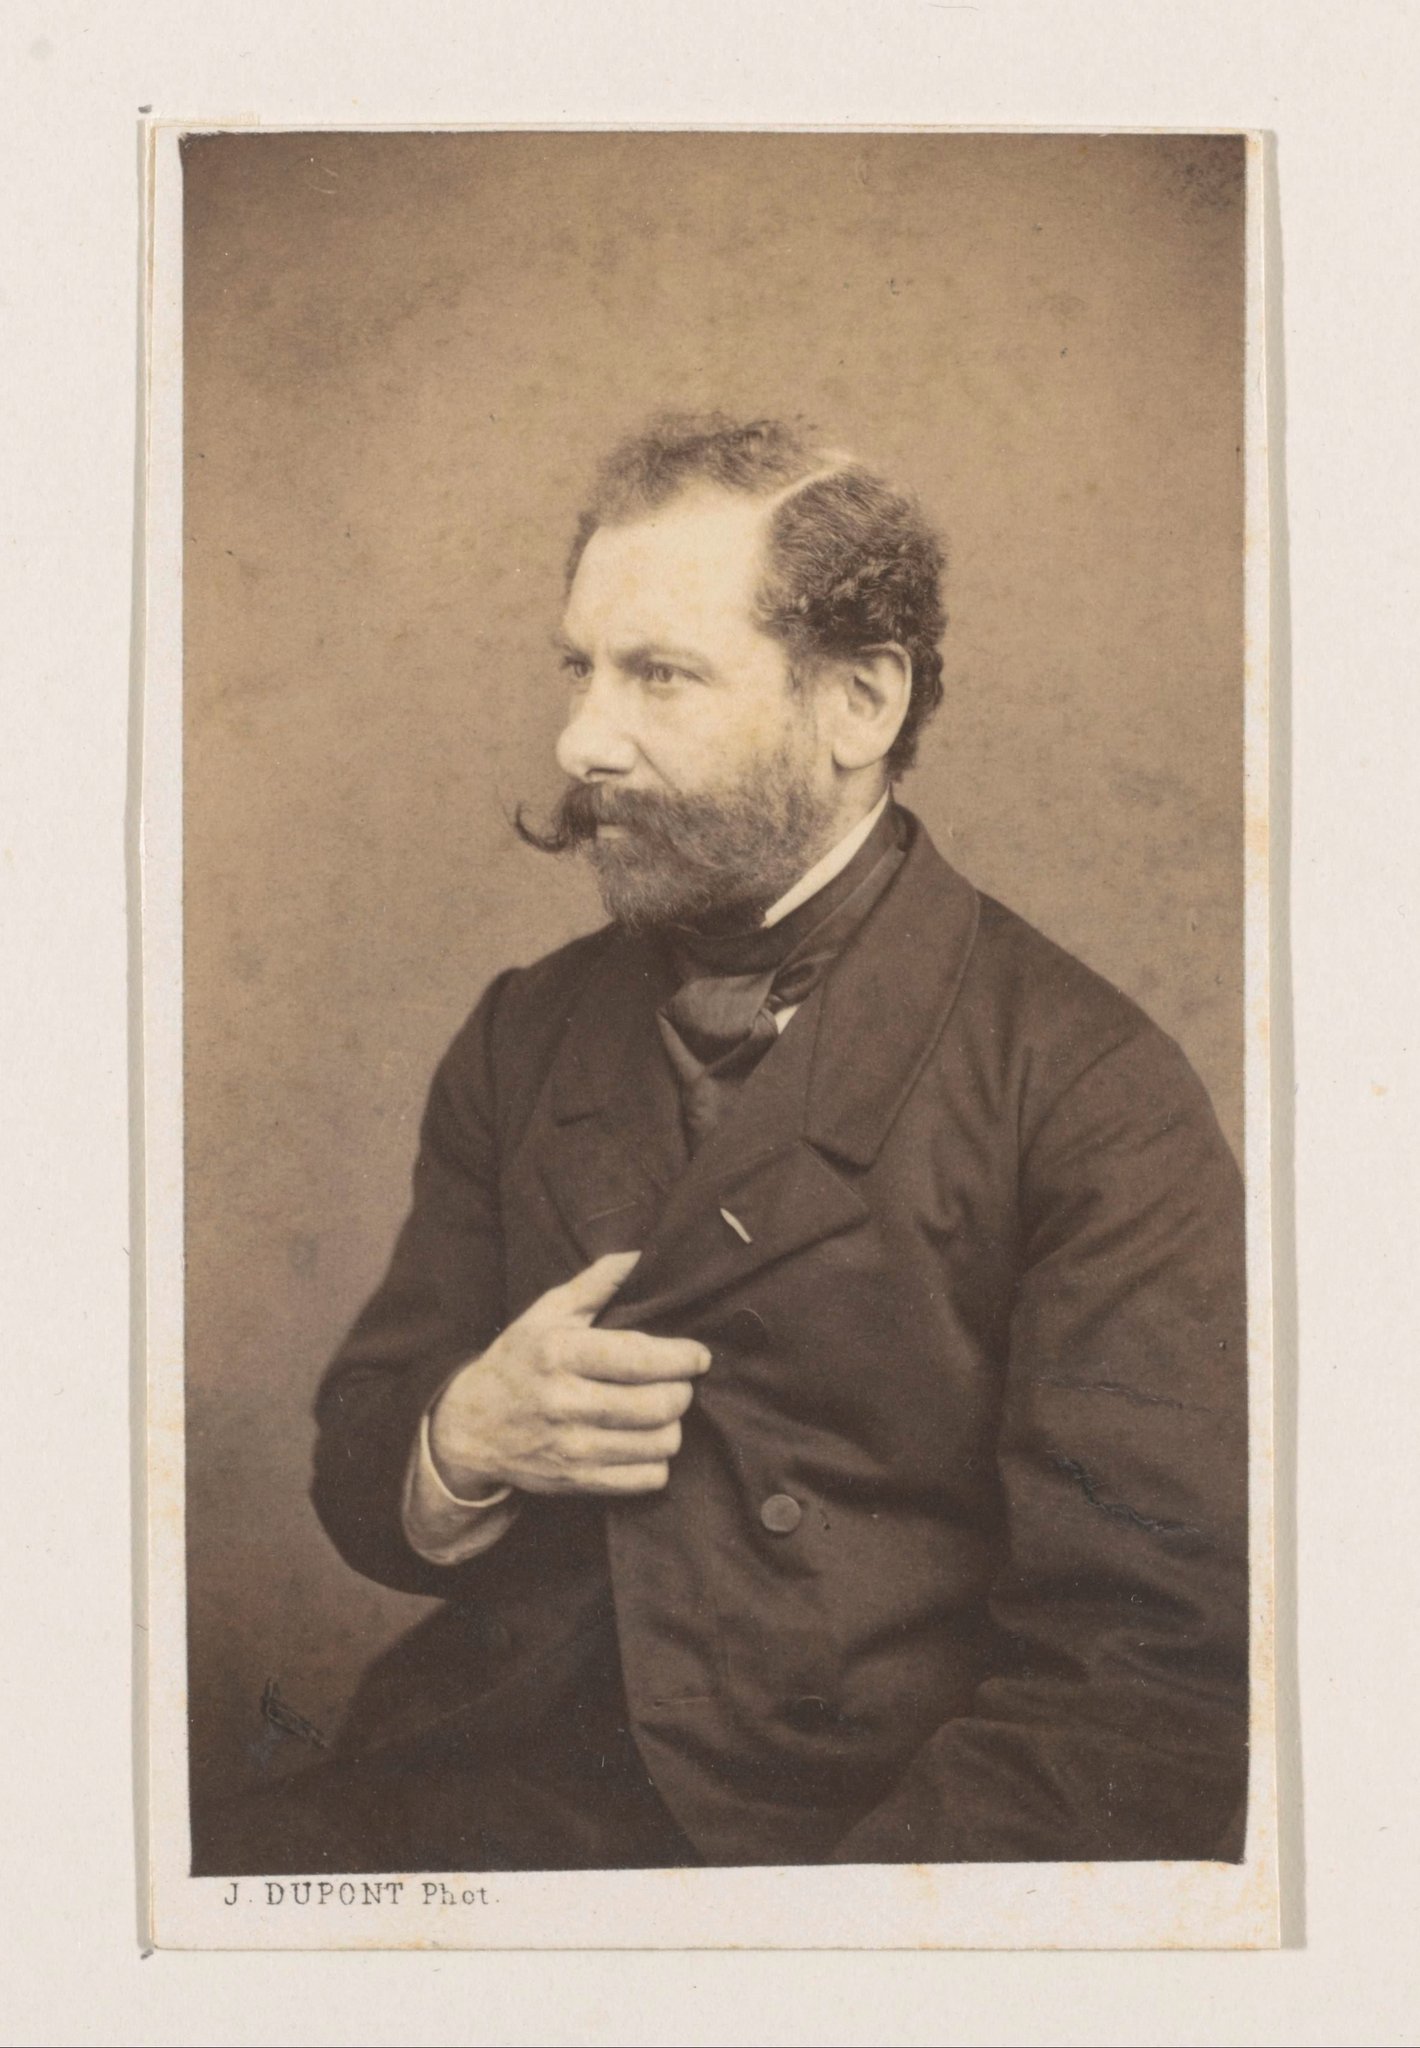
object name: photograph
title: L'École d'Anvers. Portraits biographies cartes de visite. Collection Dupont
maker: joseph dupont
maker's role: fotograaf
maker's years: 1818-1901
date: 1861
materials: cardboard, paper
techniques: albumen print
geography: antwerp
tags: antwerp, painter, sculptor, portrait, self-portrait of sculptor, historical persons, portrait, self-portrait of painter, portrait, self-portrait of artist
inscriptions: inscription: ‘ETABLISSEMENT PHOTOGRAPHIQUE/ de/ J. DUPONT/ Place de Meir 32/ ANVERS/ Maison fondée en 1853’